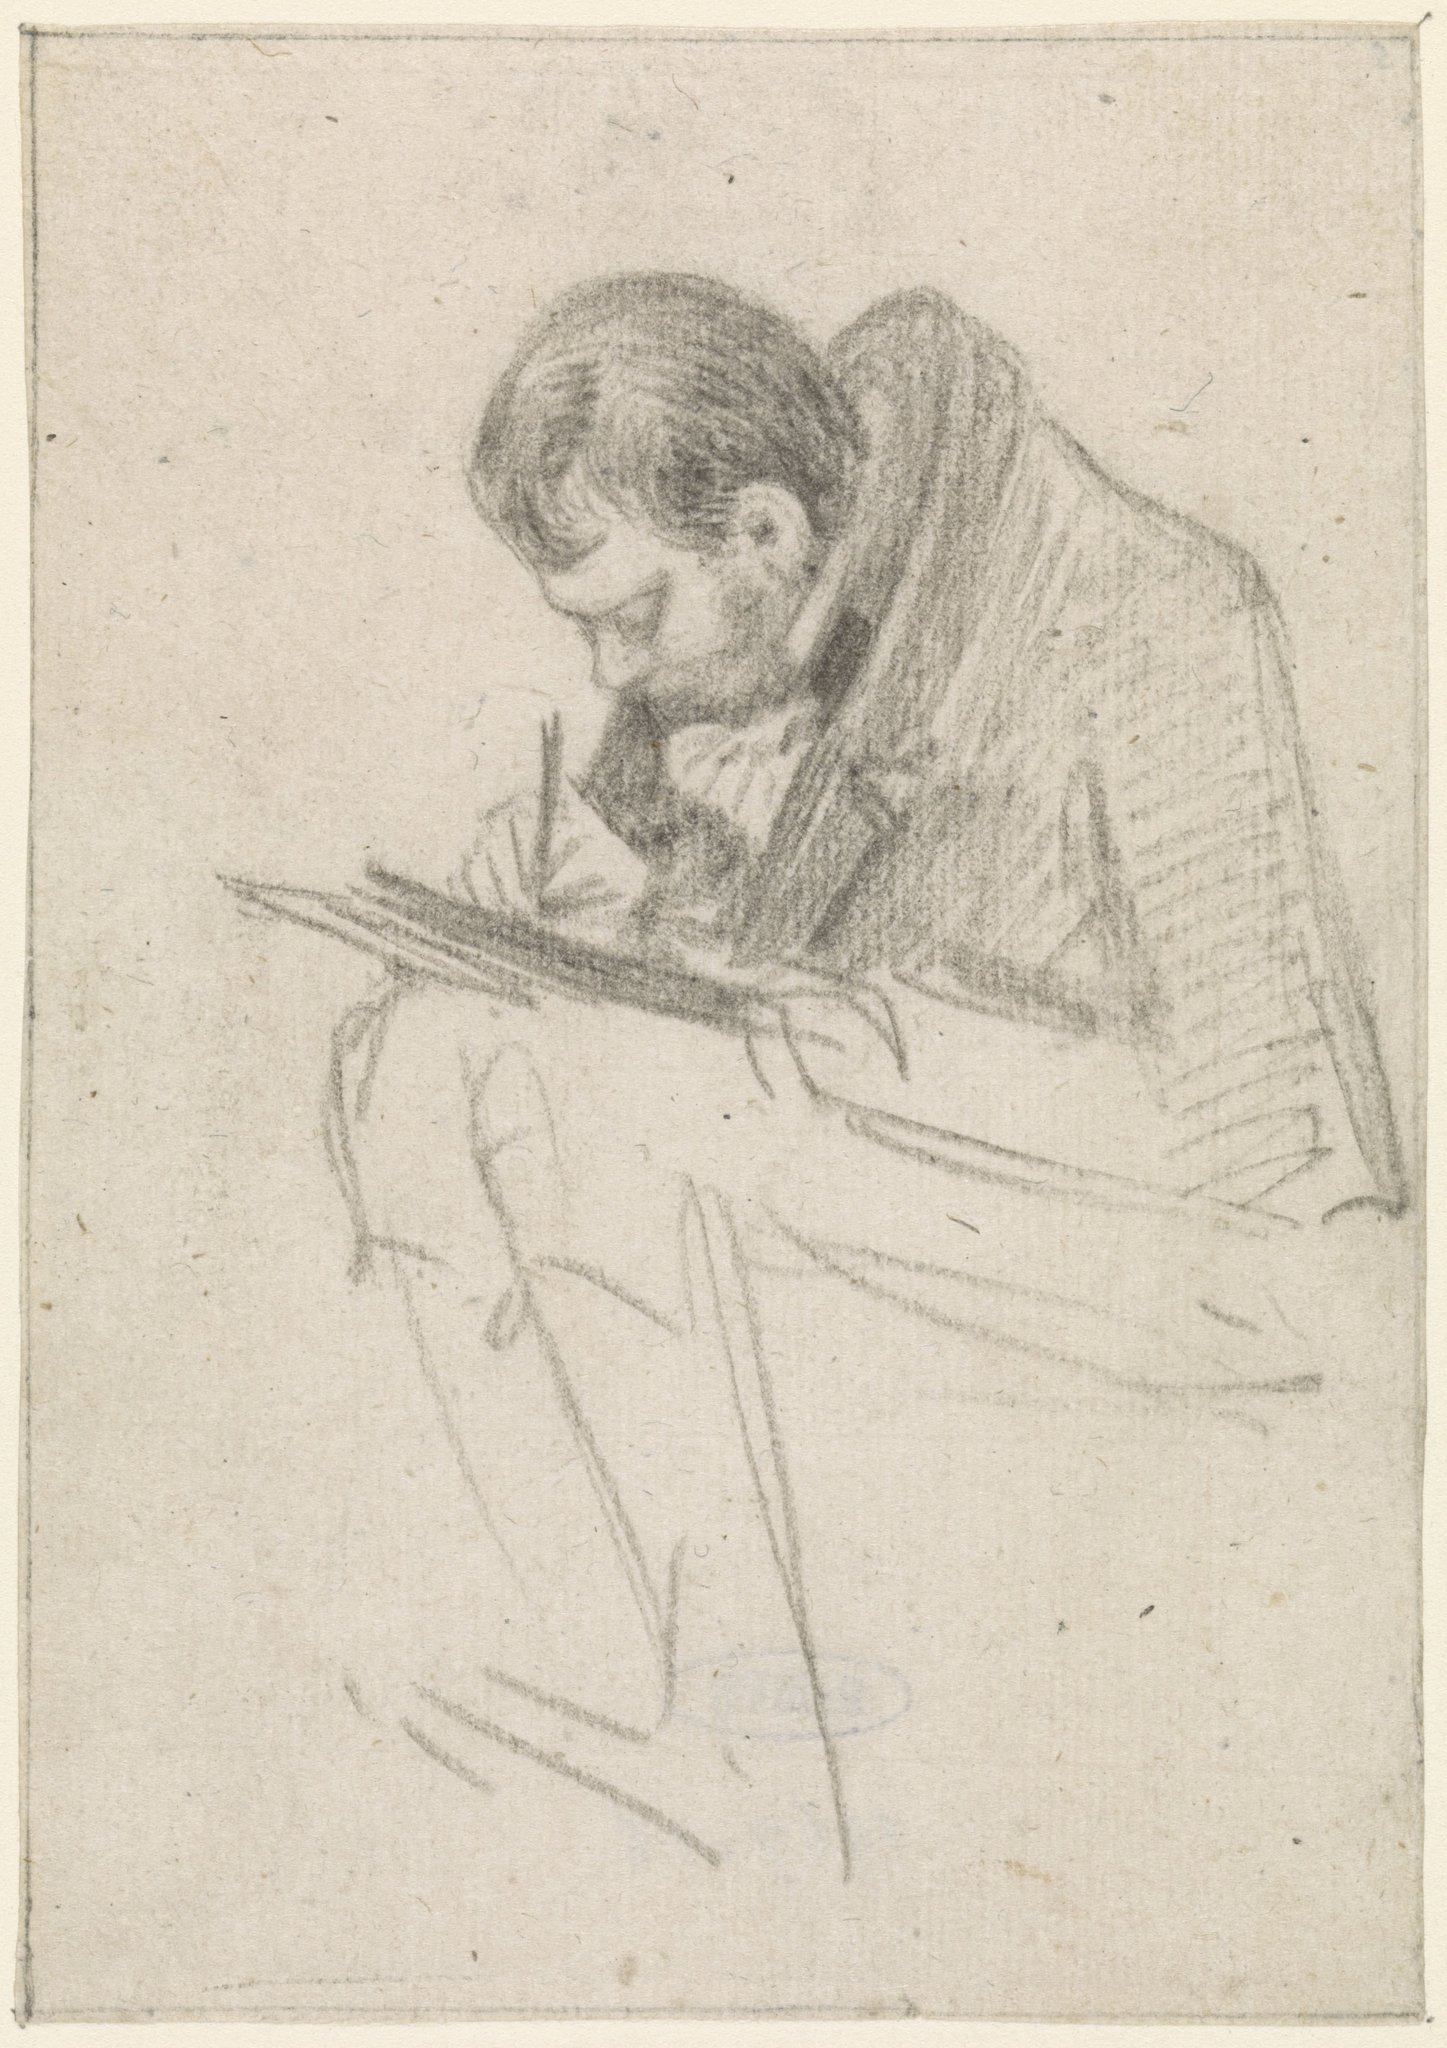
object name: drawing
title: Portret van Albertus Brondgeest al tekenend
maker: wouter johannes van troostwijk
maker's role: draughtsman, painter, print maker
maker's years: 1782-1810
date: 1800-1810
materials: chalk, paper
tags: amsterdam, print maker, draughtsman, albertus brondgeest, historical persons, portrait, self-portrait of painter, portrait, self-portrait of artist, portrait, self-portrait of draughtsman